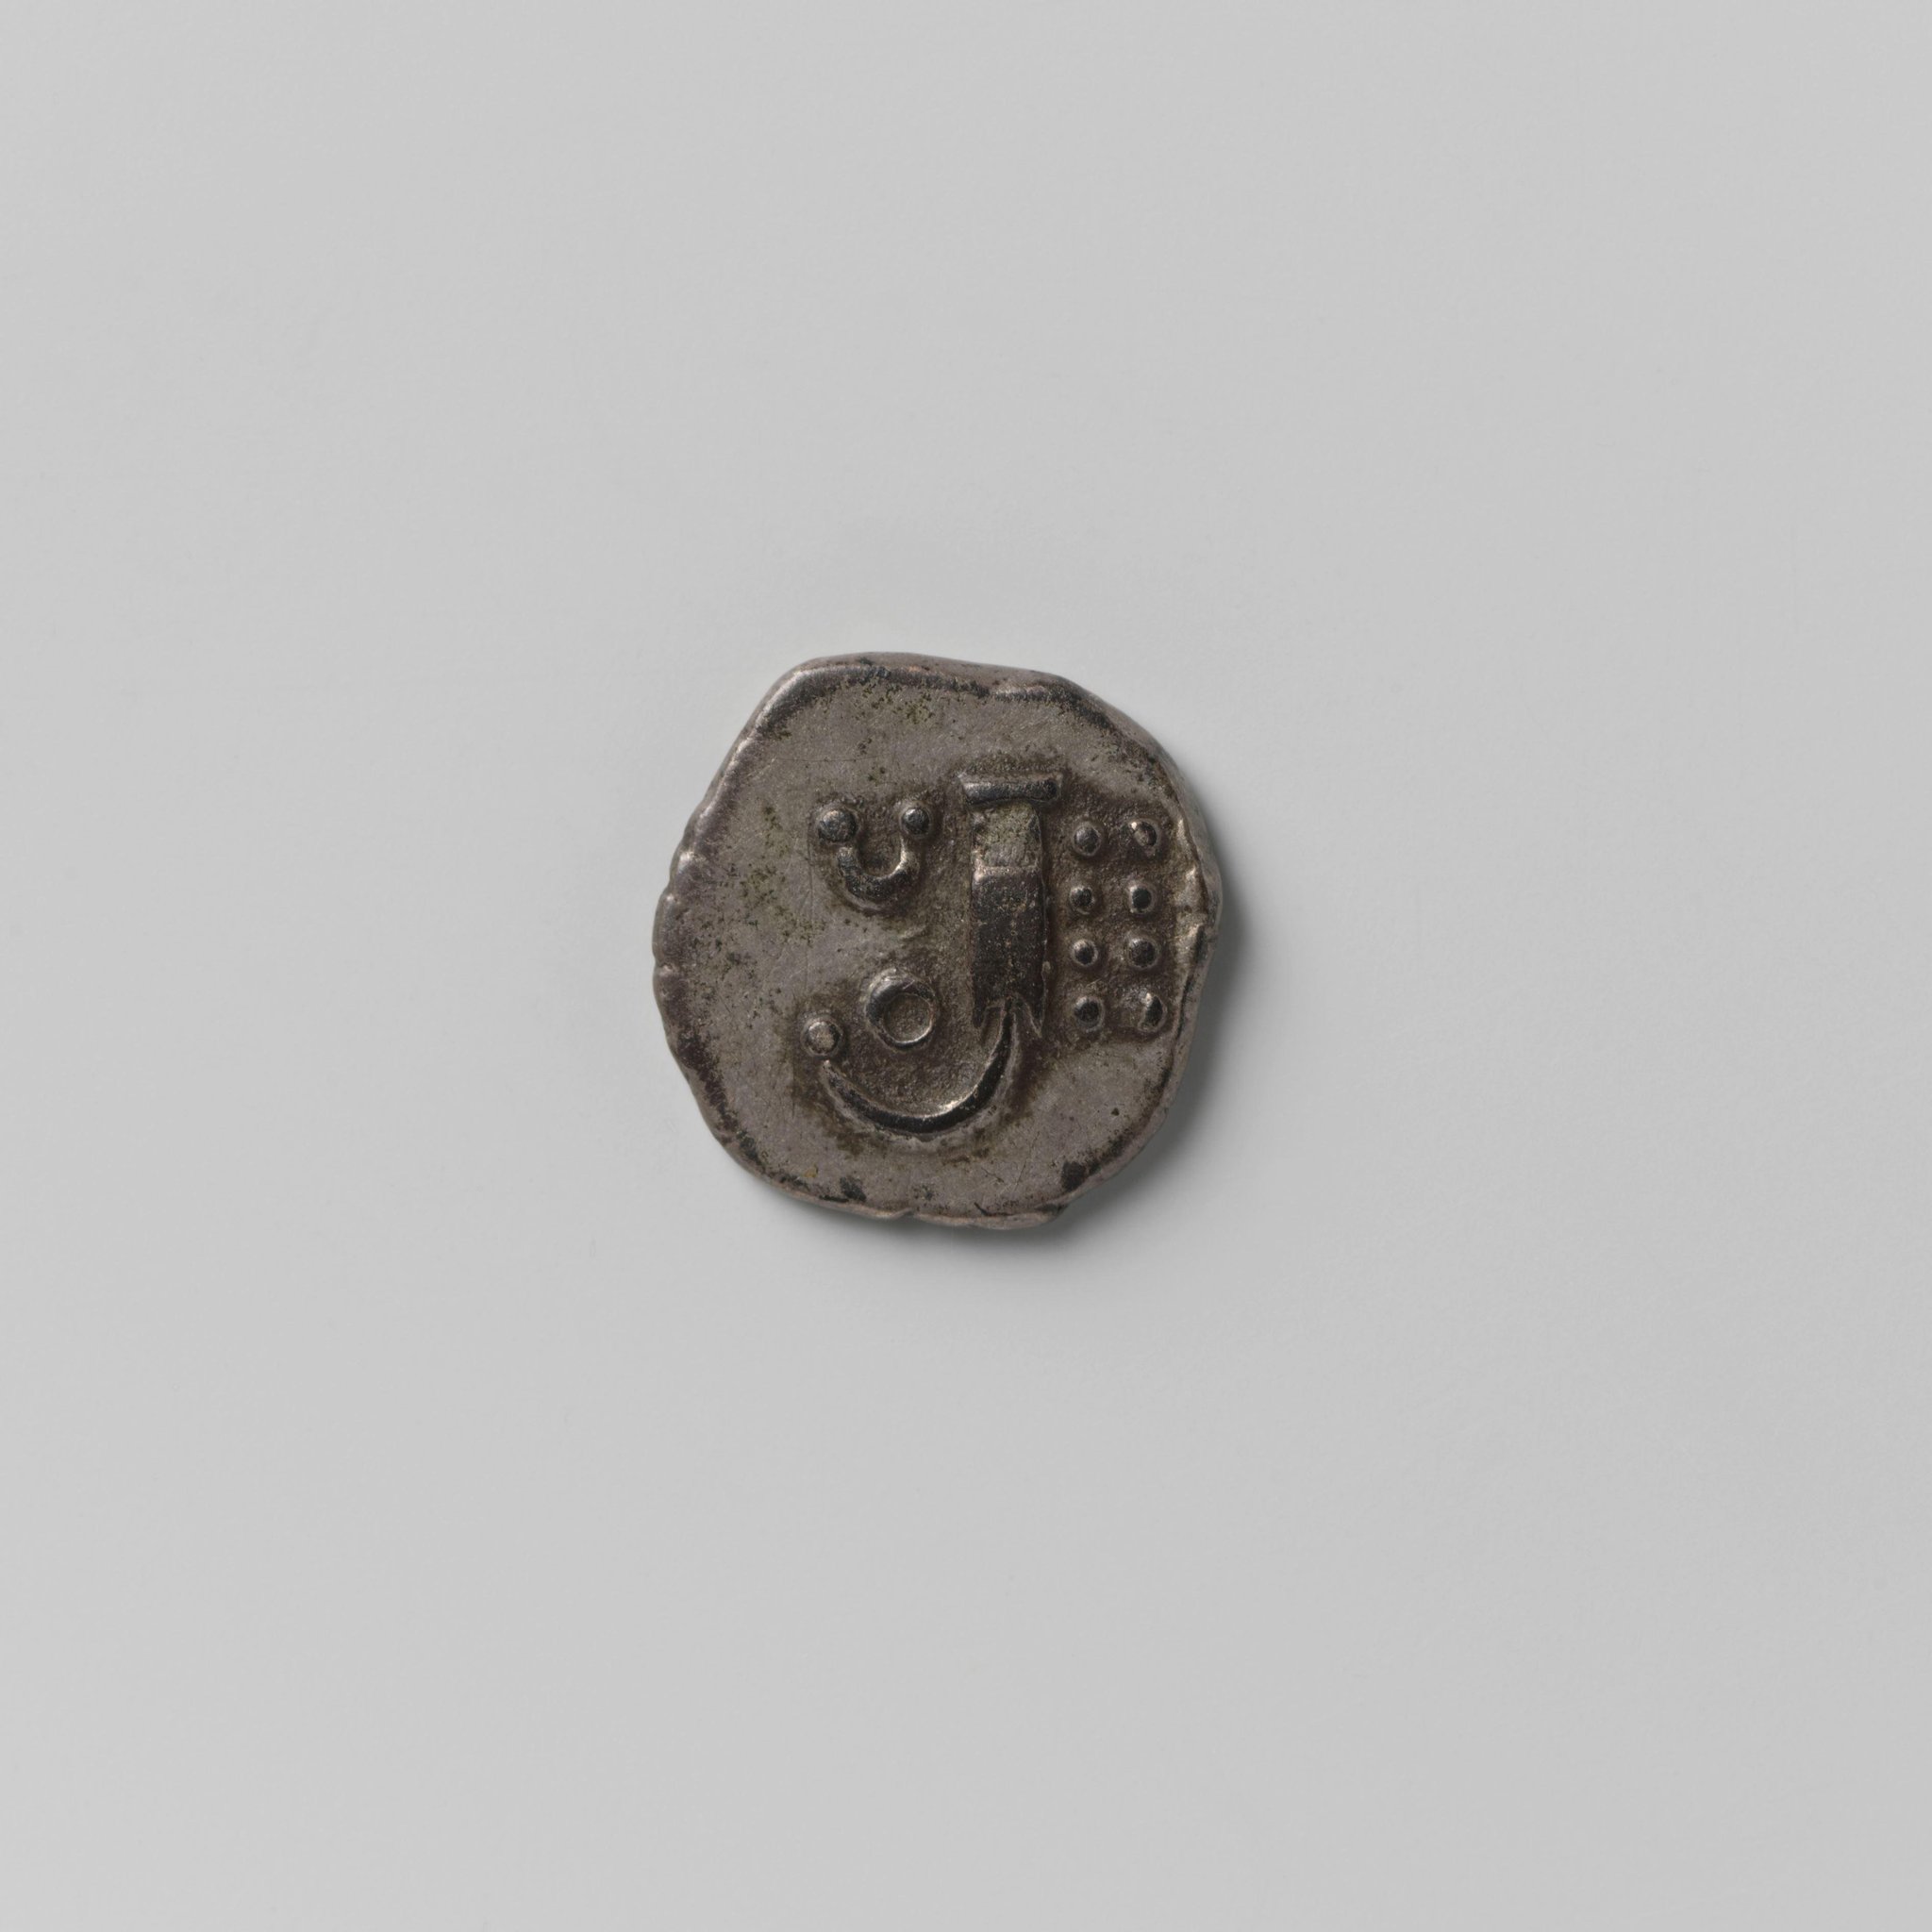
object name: coin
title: Zilveren grote fanam van Negapatnam, Voor-Indië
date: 1750-1780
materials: silver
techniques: striking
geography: negapatnam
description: Zilveren munt. Voorzijde: de Godheid Vishnu staande met kegelvormige drievoudige kroon. Terzijde van het hoofd kleppen, waarnaast een verzameling punten. Keerzijde: bolvormig oppervlak, bezaaid met punten. Gladde rand.